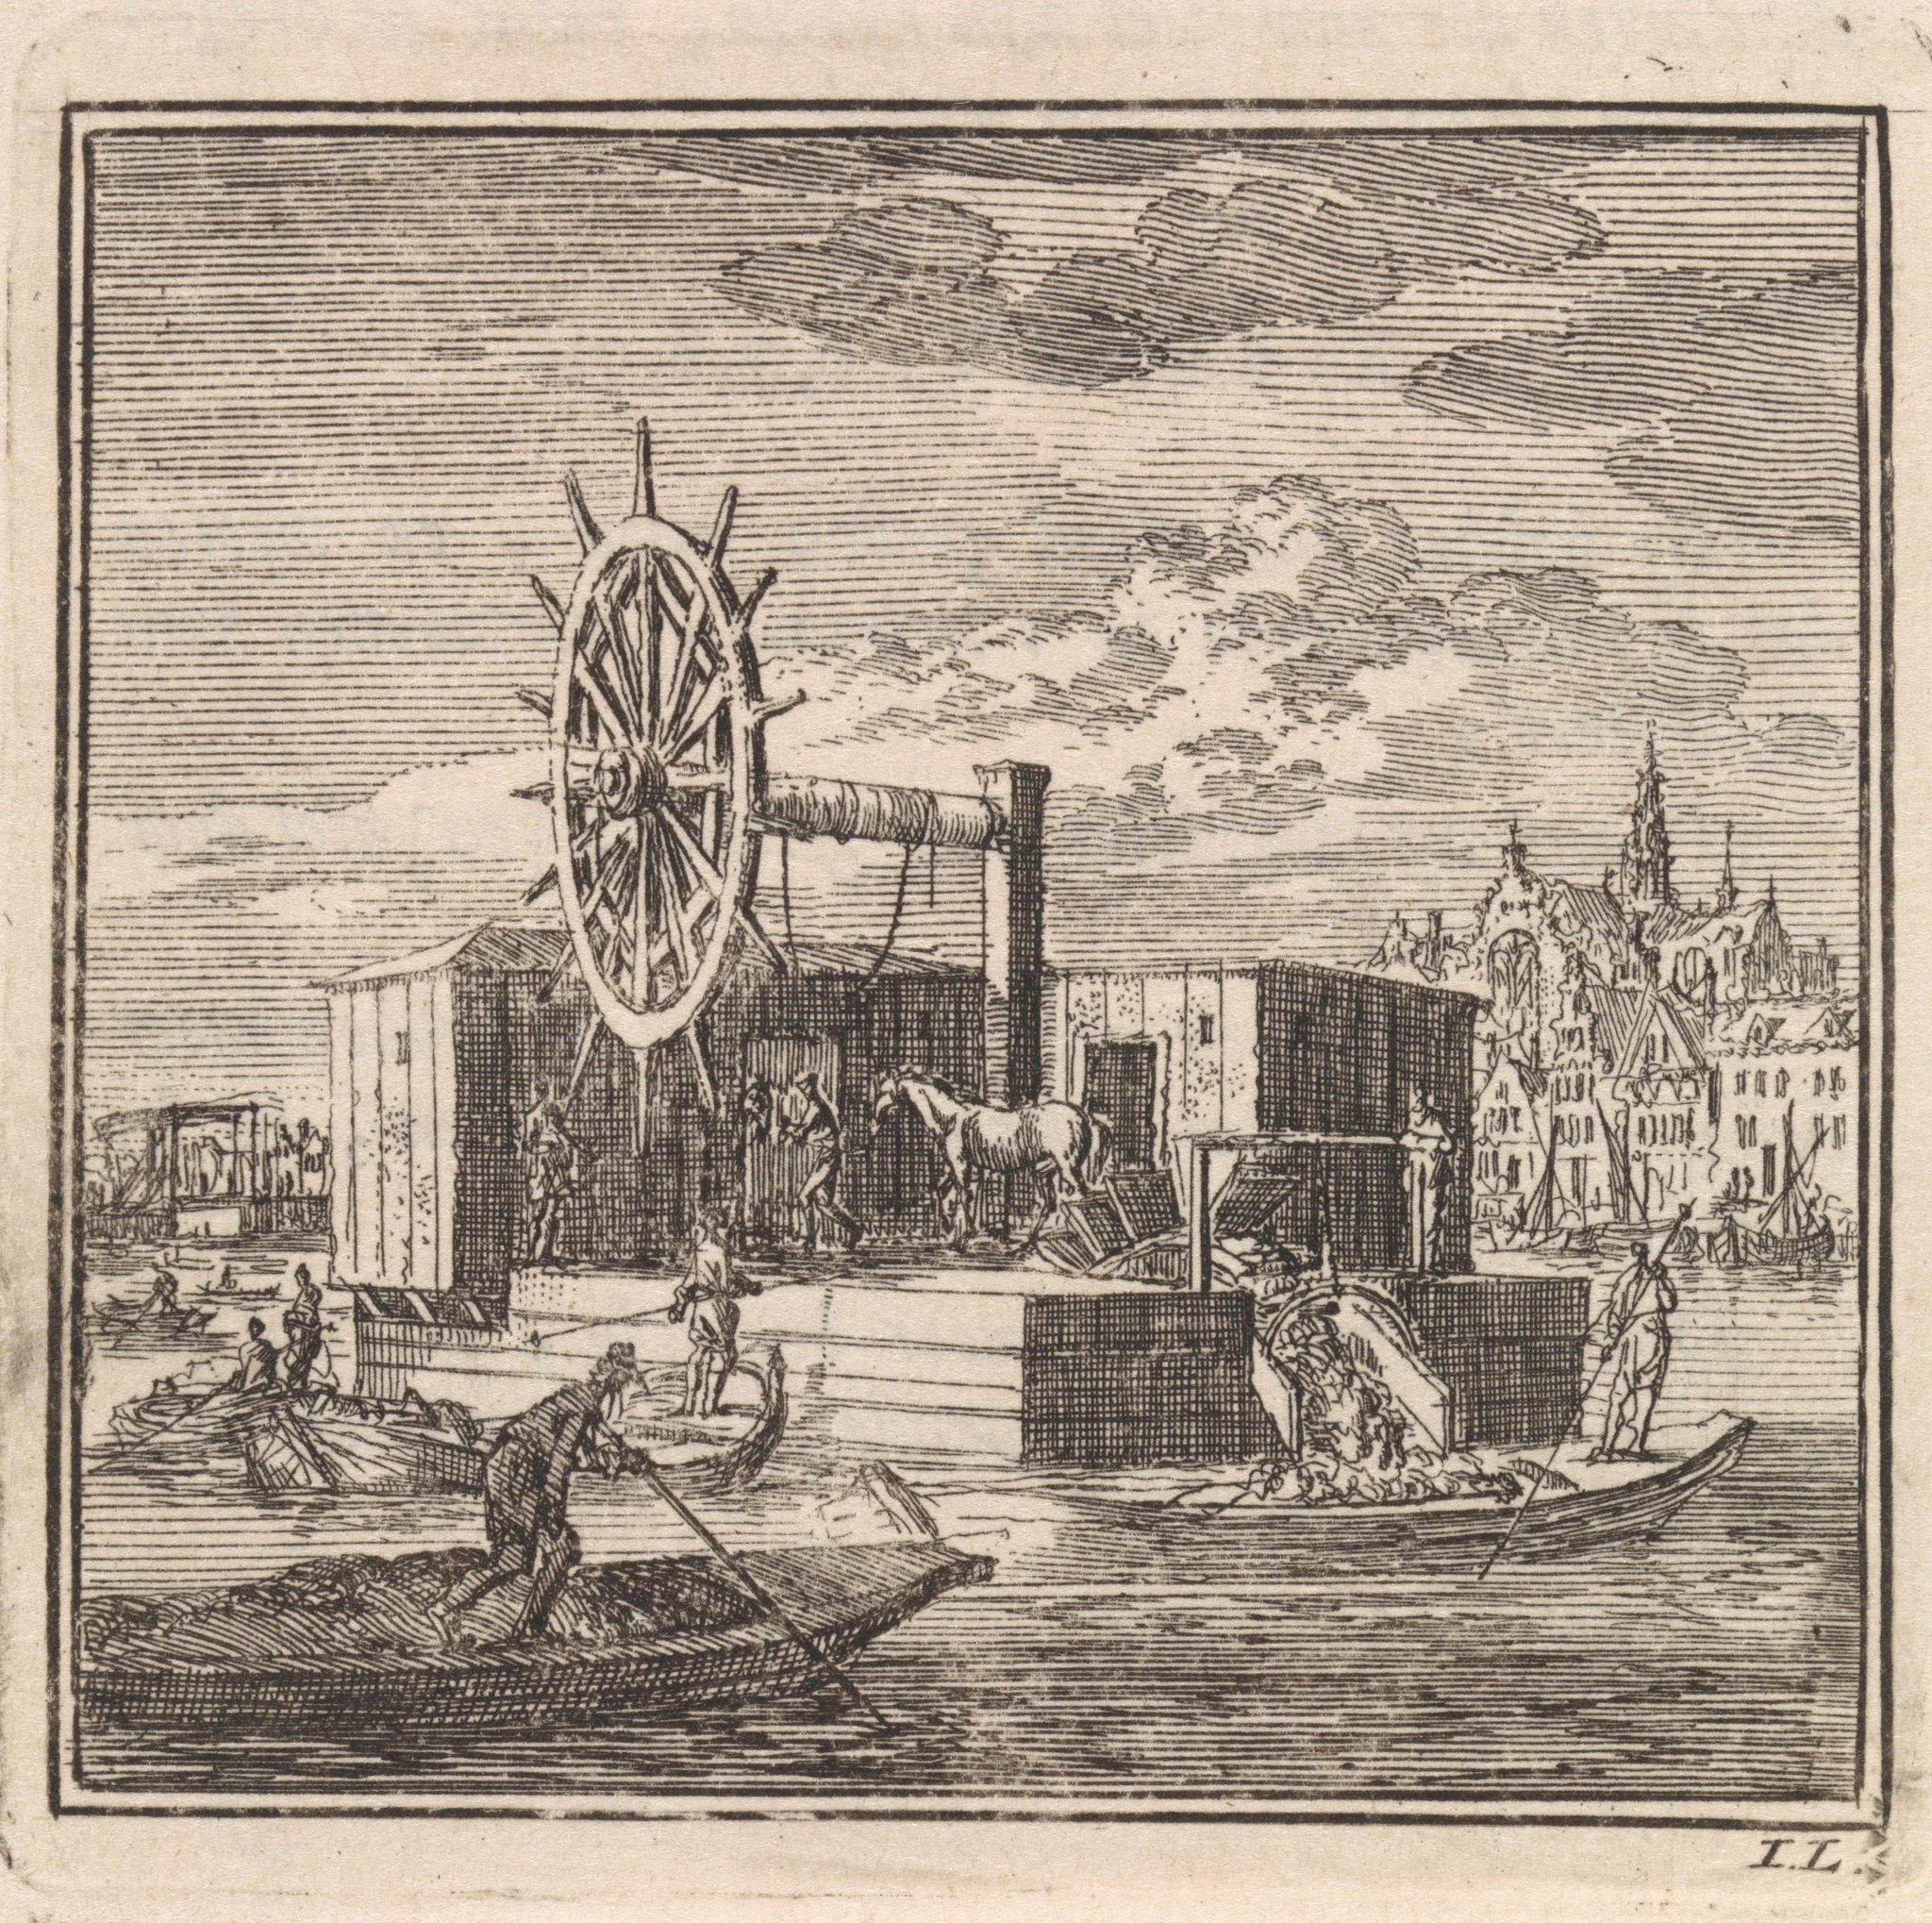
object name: print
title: Baggermolen aan de rand van een stad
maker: jan luyken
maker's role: draughtsman, print maker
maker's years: 1649-1712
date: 1711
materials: paper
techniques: etching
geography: amsterdam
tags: city-view in general; 'veduta', dredge, dredging machine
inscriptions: collector's mark: Lugt 2228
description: Illustratie voor: Luyken, Jan. De Bykorf des Gemoeds. Amsterdam: Pieter Arentsz. II (wed.) en Cornelis van der Sys, 1711, p. 62.